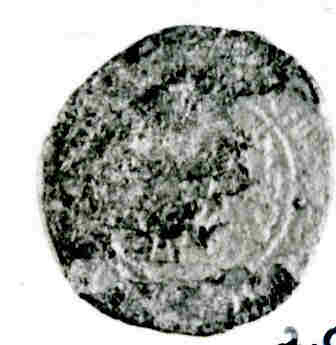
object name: coin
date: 701-900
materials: copper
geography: iran